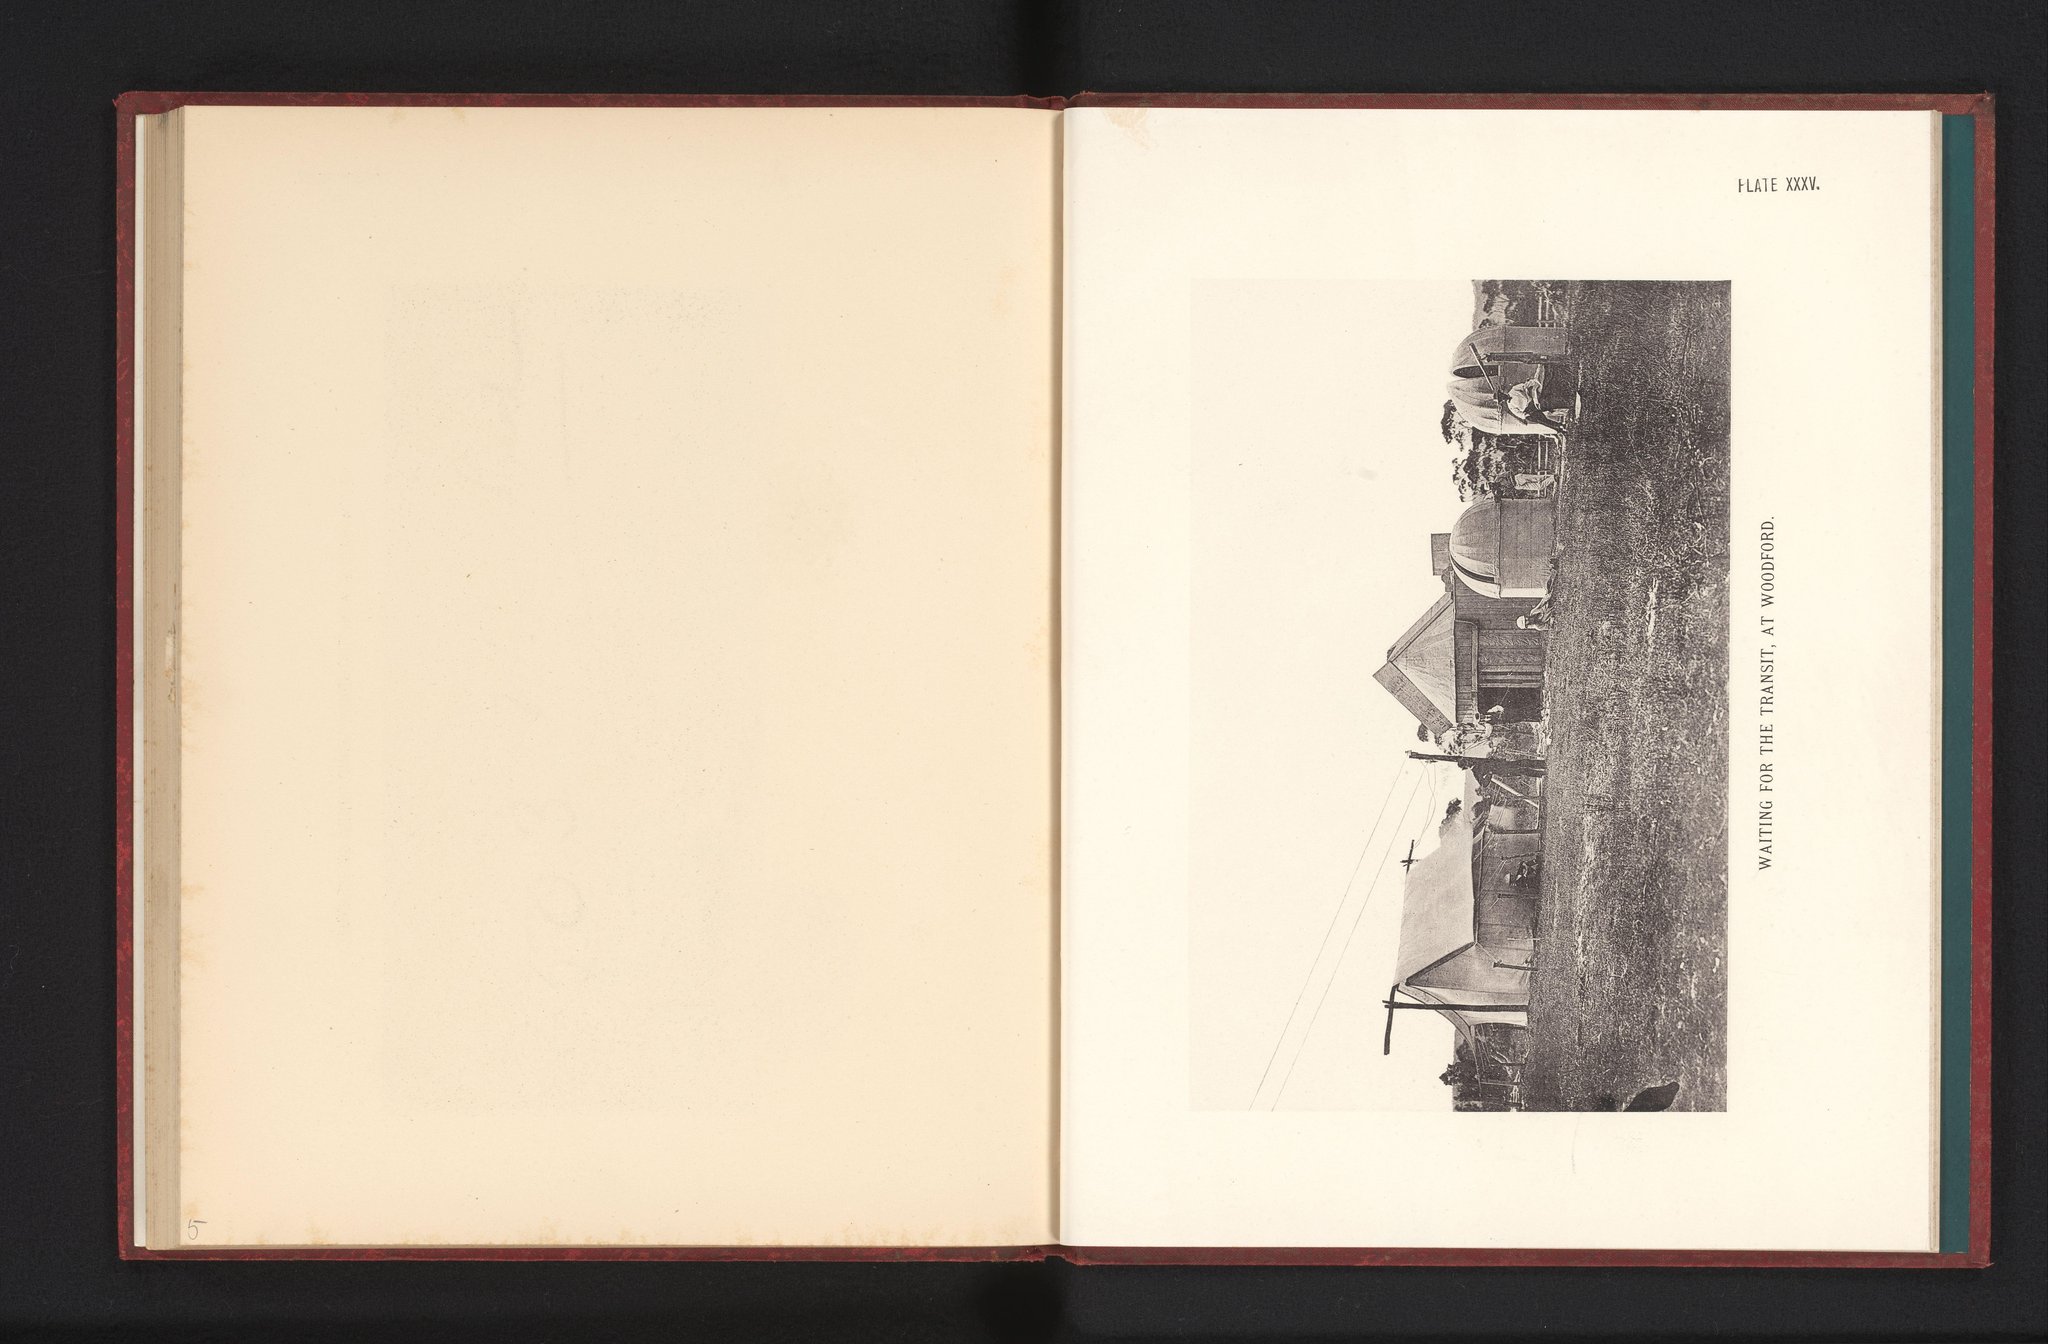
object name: photomechanical print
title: Waiting for the transit, at Woodford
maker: Anonymous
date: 1882-1892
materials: paper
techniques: photograph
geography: woodford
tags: tent-camp, astronomical phenomena, astronomy (and cosmography)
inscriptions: number: ‘Plate XXXV.’